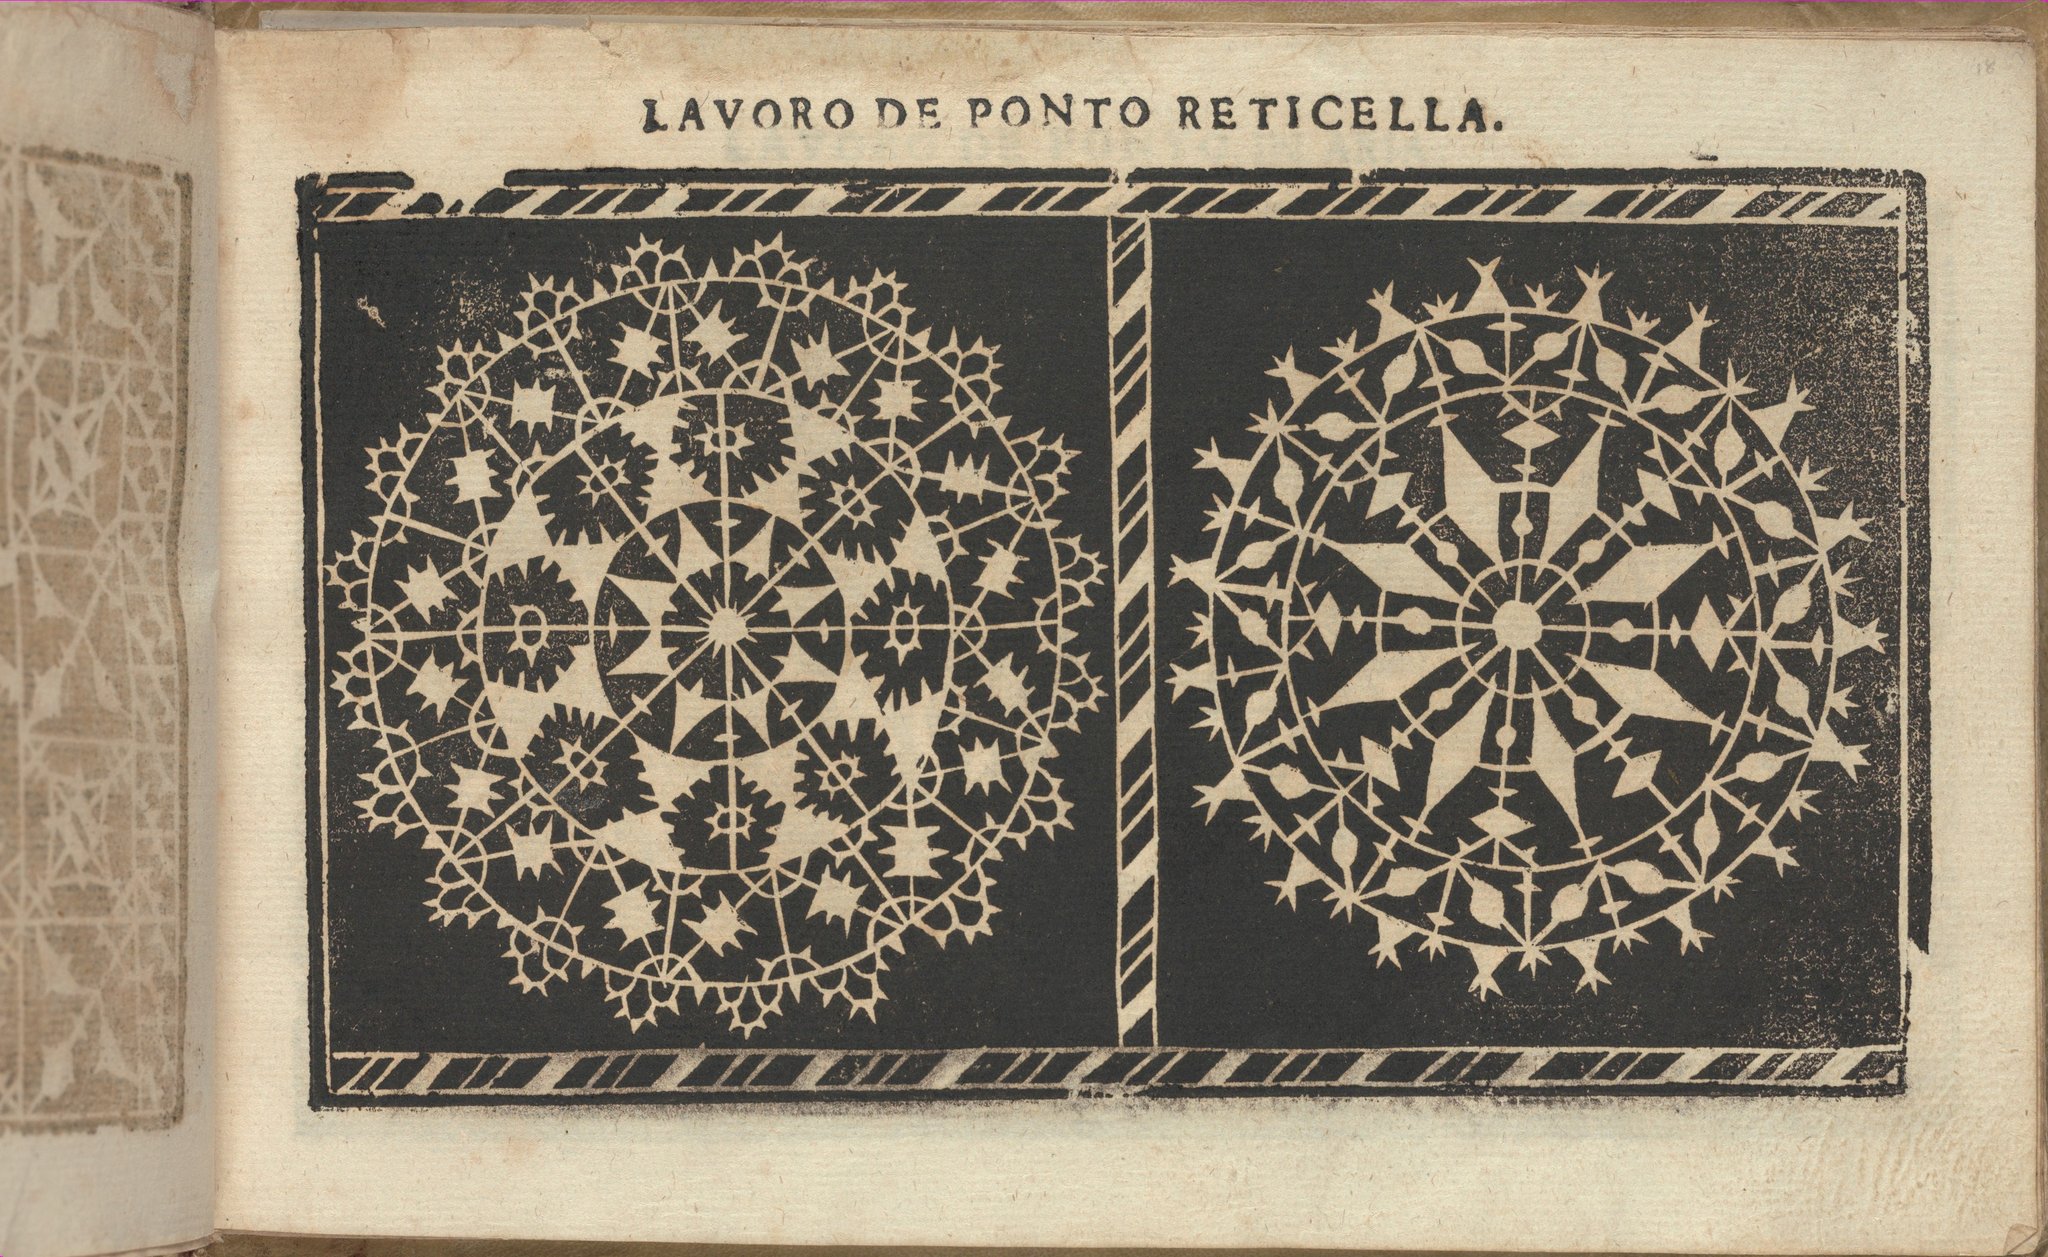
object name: book print ornament architecture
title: Studio delle virtuose Dame, page 18 (recto)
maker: isabella catanea parasole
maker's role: designer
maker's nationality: italian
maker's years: 1565-1625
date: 1597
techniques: woodcut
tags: ornament